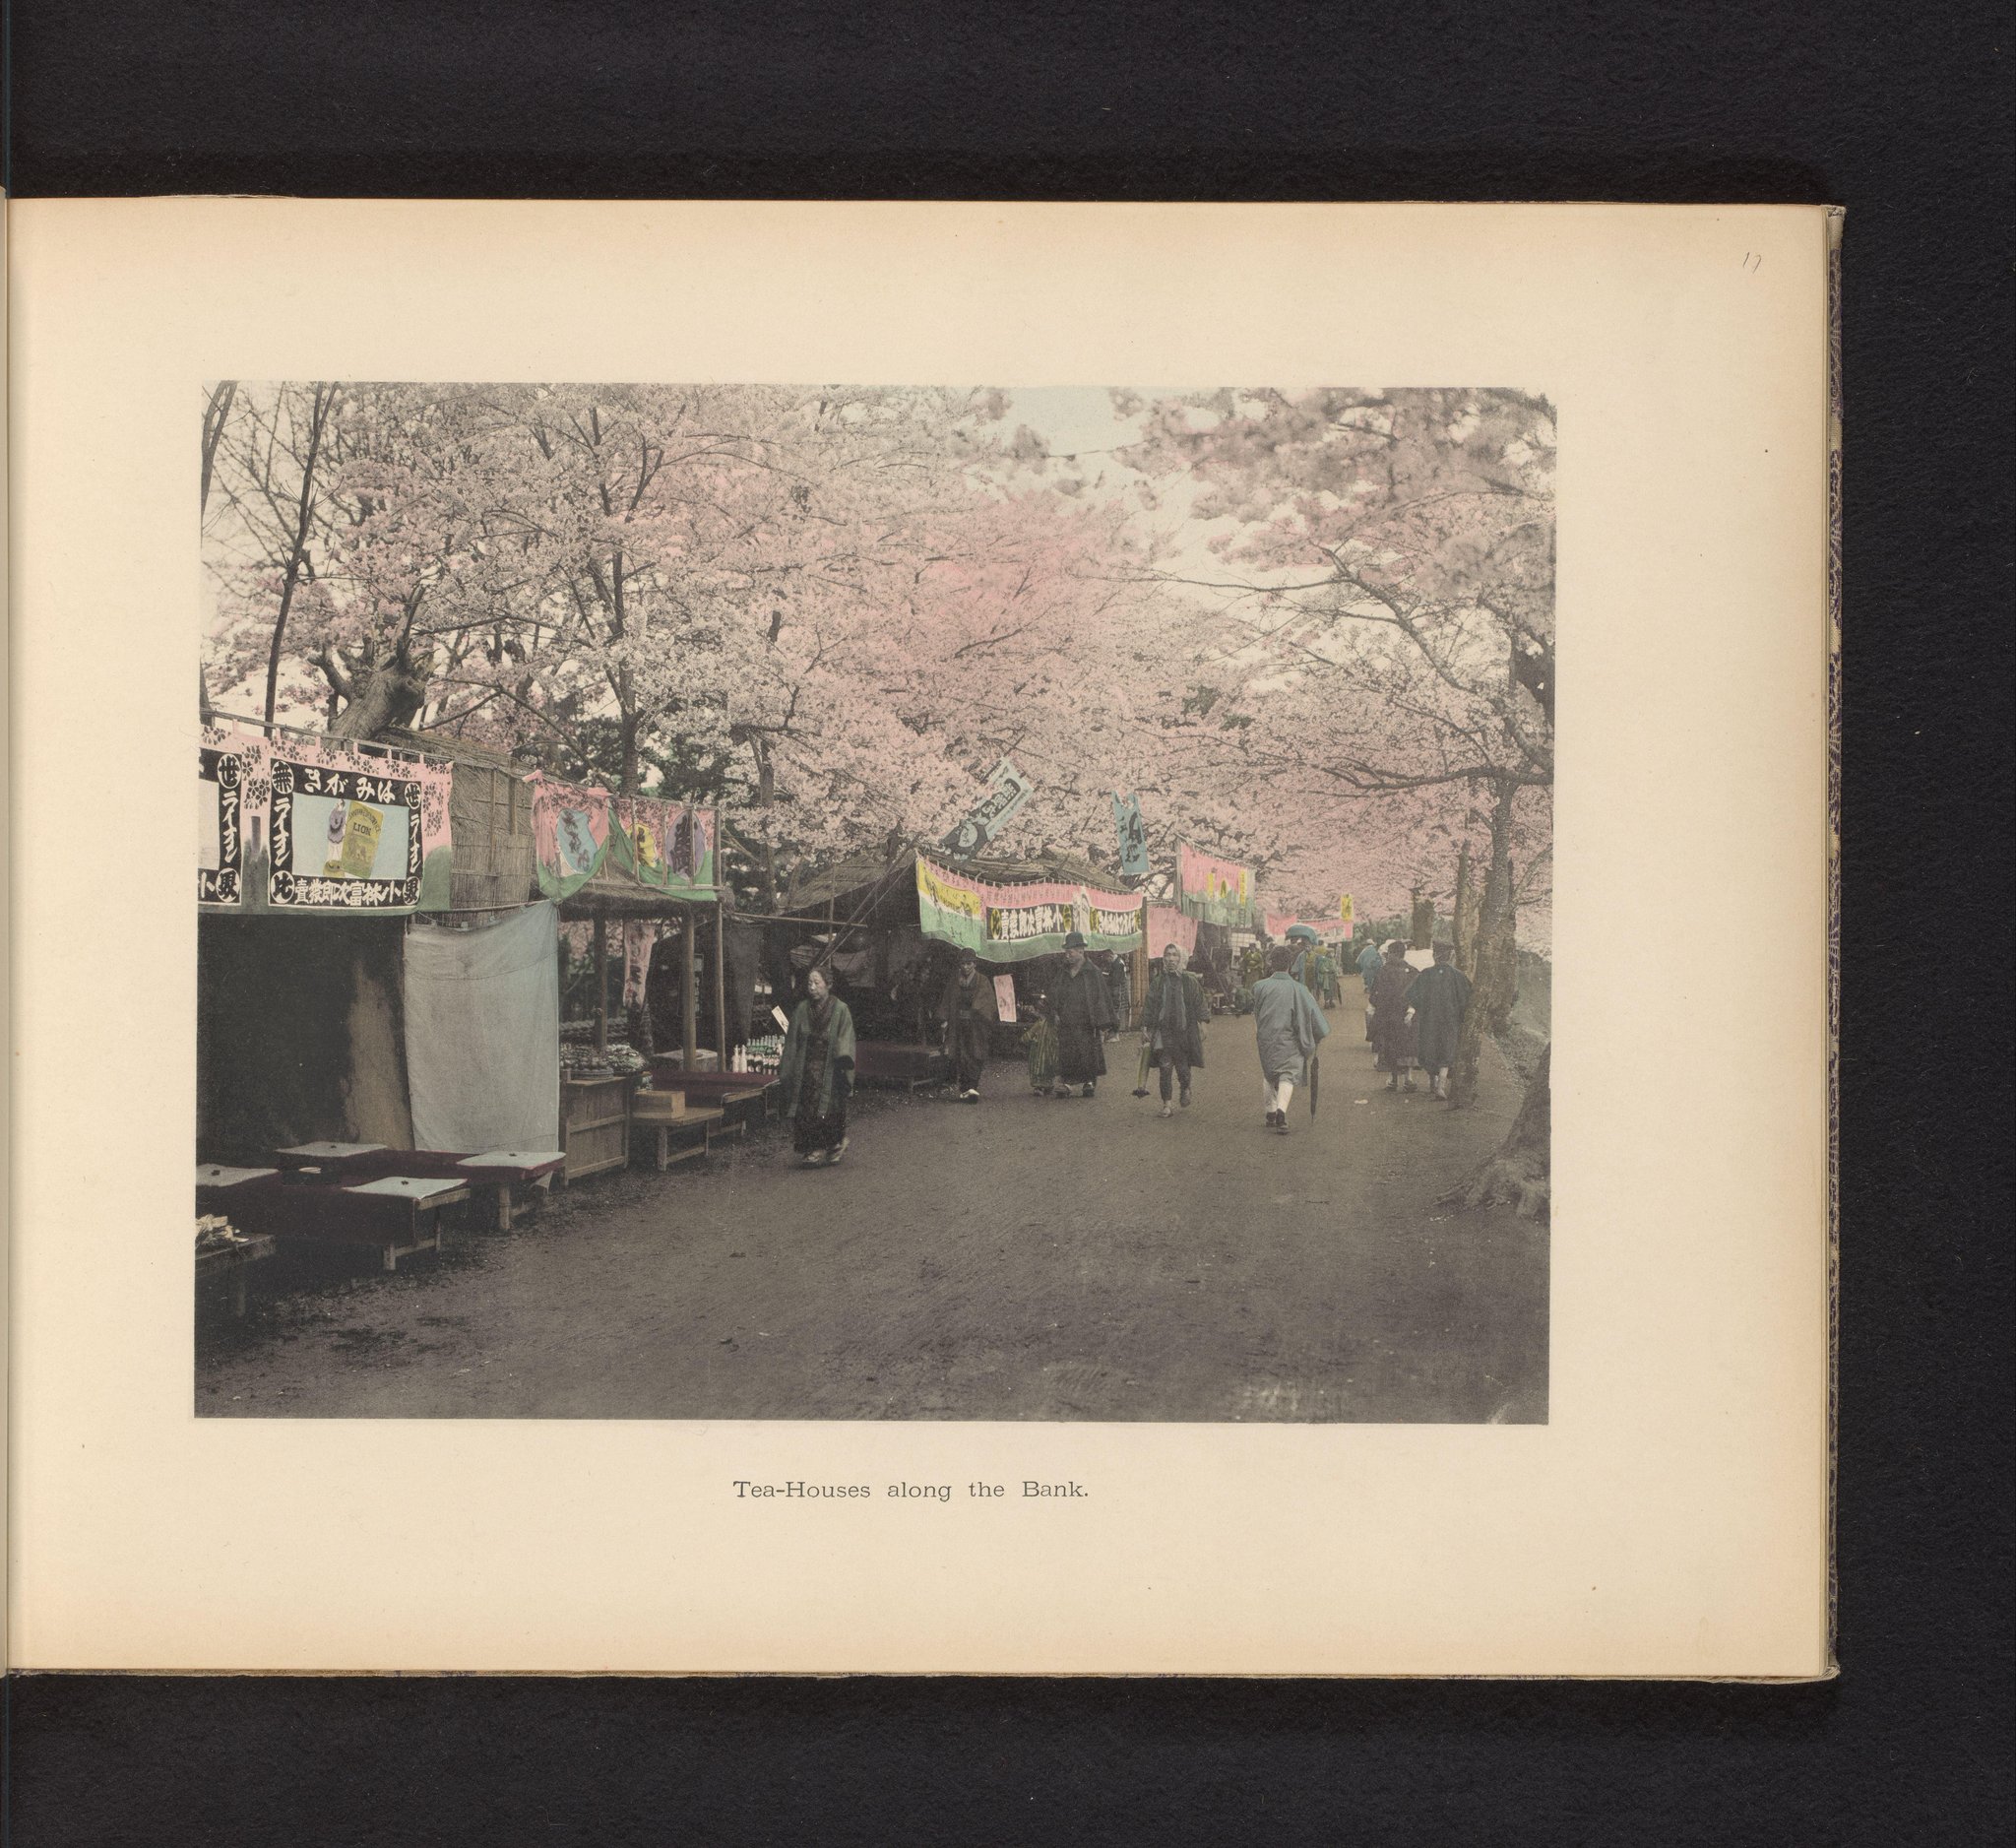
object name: page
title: Tea-Houses along the Bank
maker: kazumasa ogawa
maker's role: auteur, fotograaf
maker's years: 1860-1929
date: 1892-1897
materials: paper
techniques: photograph, hand coloring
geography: uenopark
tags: park, tea garden, garden restaurant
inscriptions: number: ‘17’